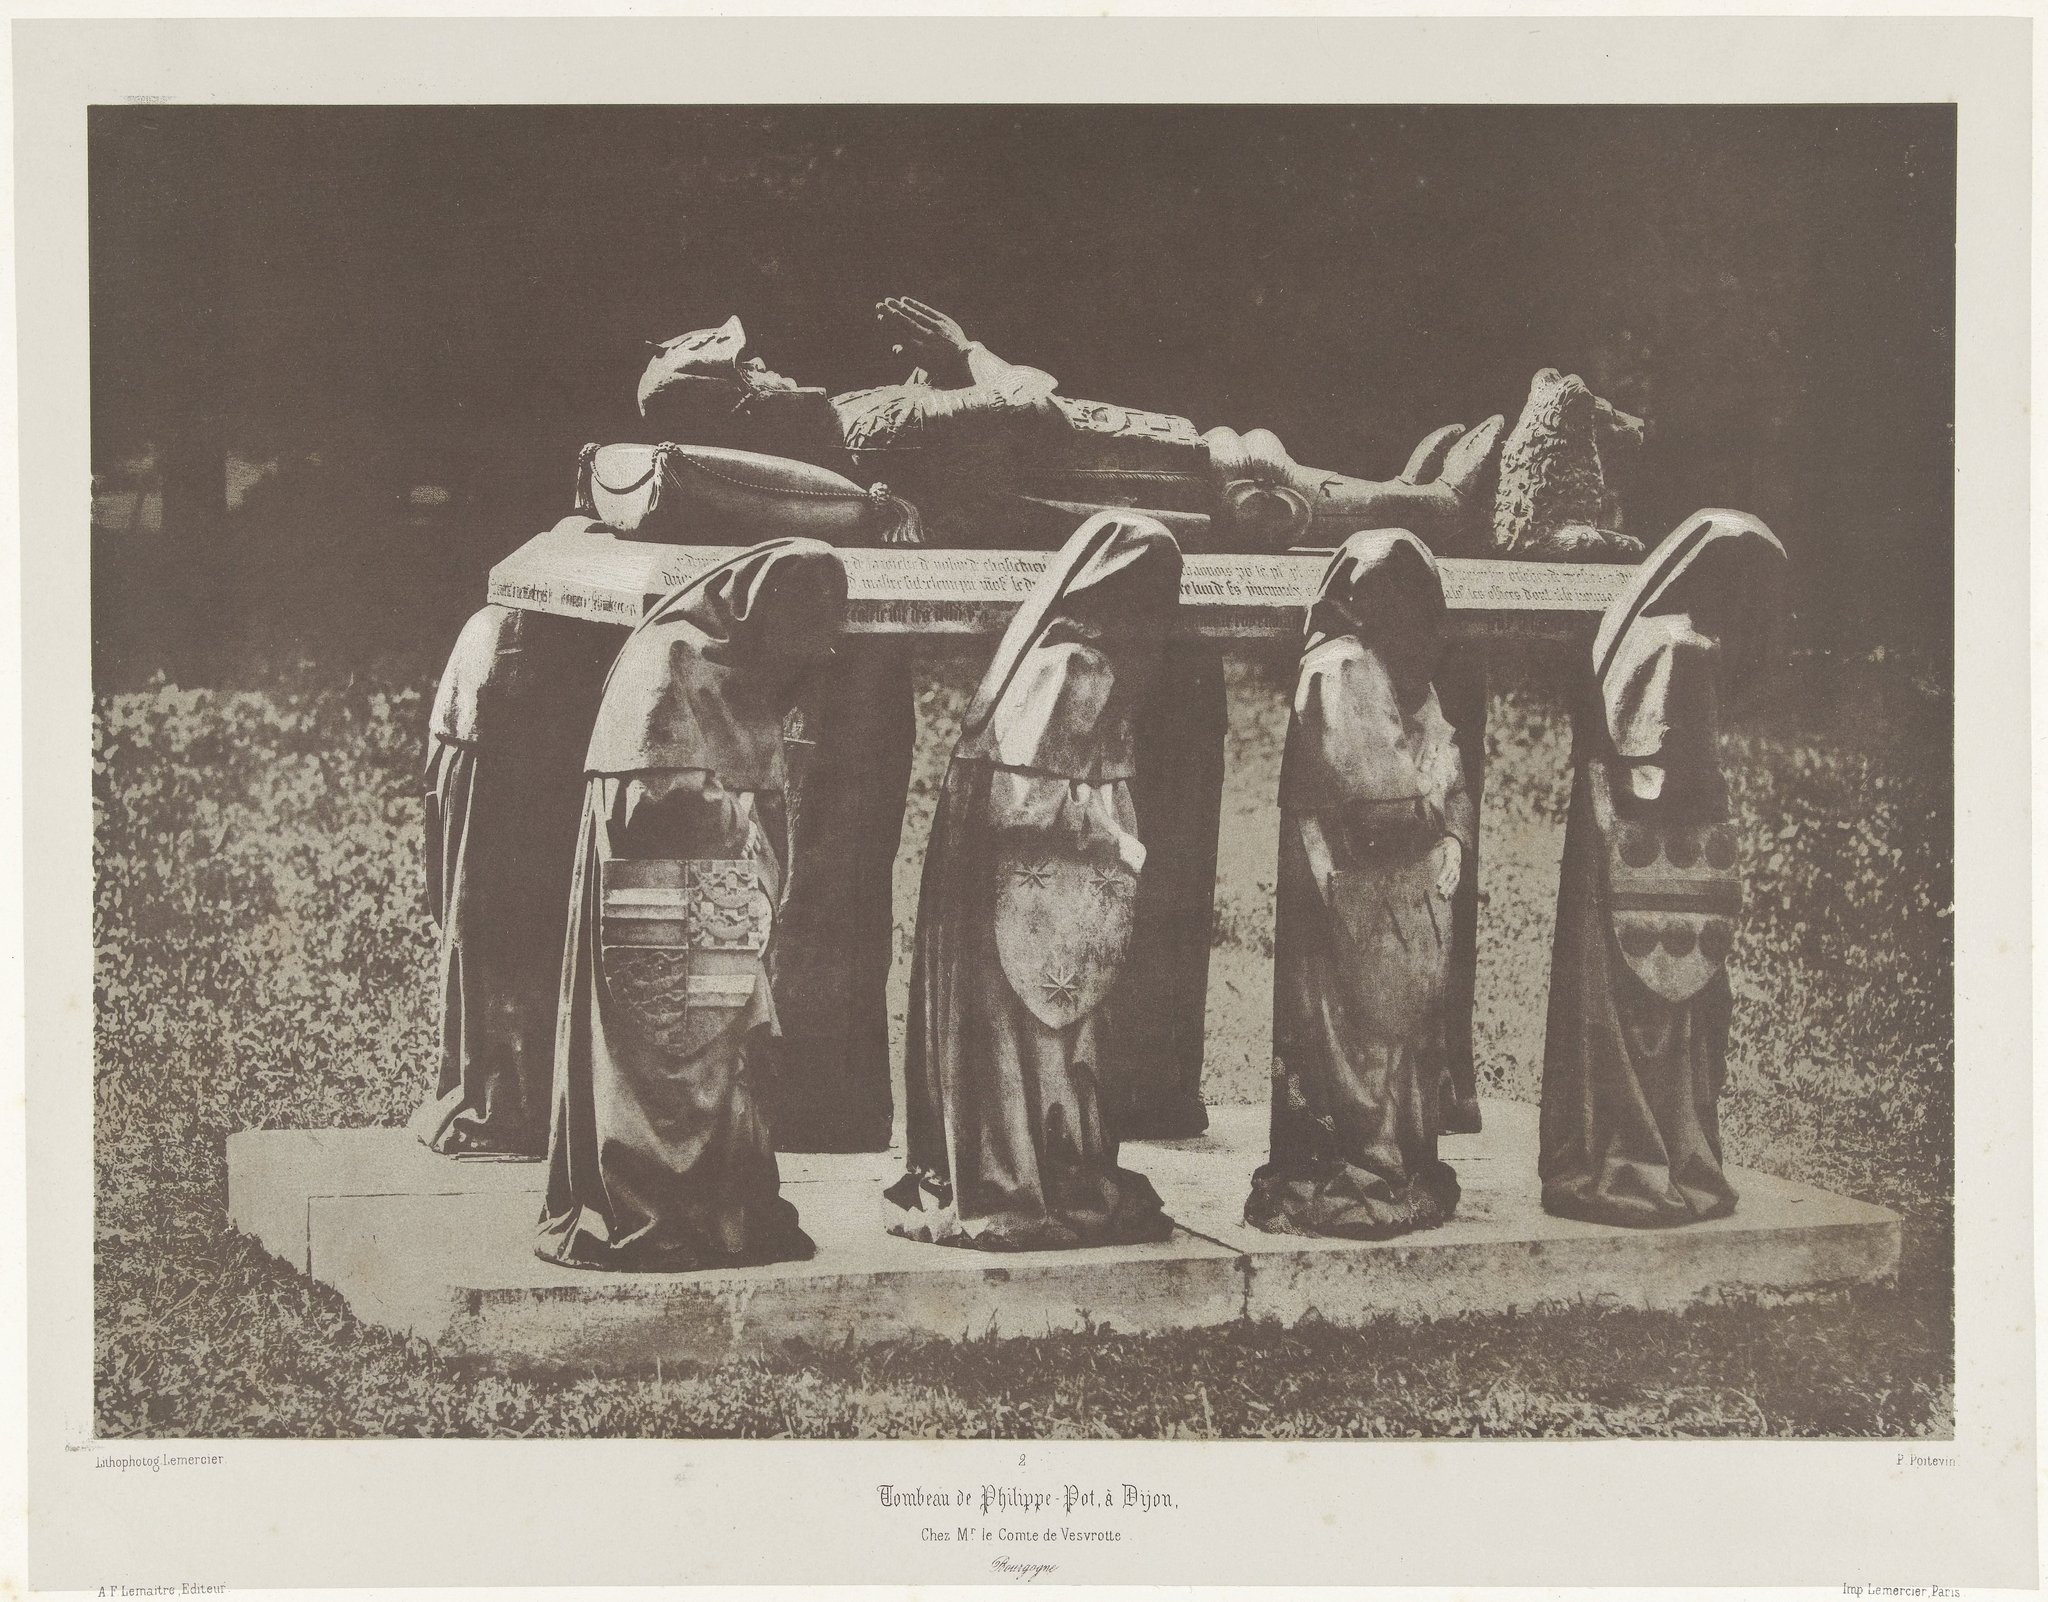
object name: photomechanical print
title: Grafmonument voor Philippe Pot te Dijon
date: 1857-1870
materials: cardboard, paper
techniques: photolithography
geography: france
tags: grave-building, monumental tomb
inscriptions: inscription: ‘19y’, title: ‘Tombeau de Philippe-Pot, à Dijon,/ Chez Mr. Le Comte de Vesvrotte/ Bourgogne’, number: ‘2’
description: Het grafmonument werd tijdens de Franse Revolutie gestolen en stond in de negentiende eeuw in verschillende tuinen in Dijon. Sinds 1899 wordt het grafmonument tentoongesteld in het Louvre.